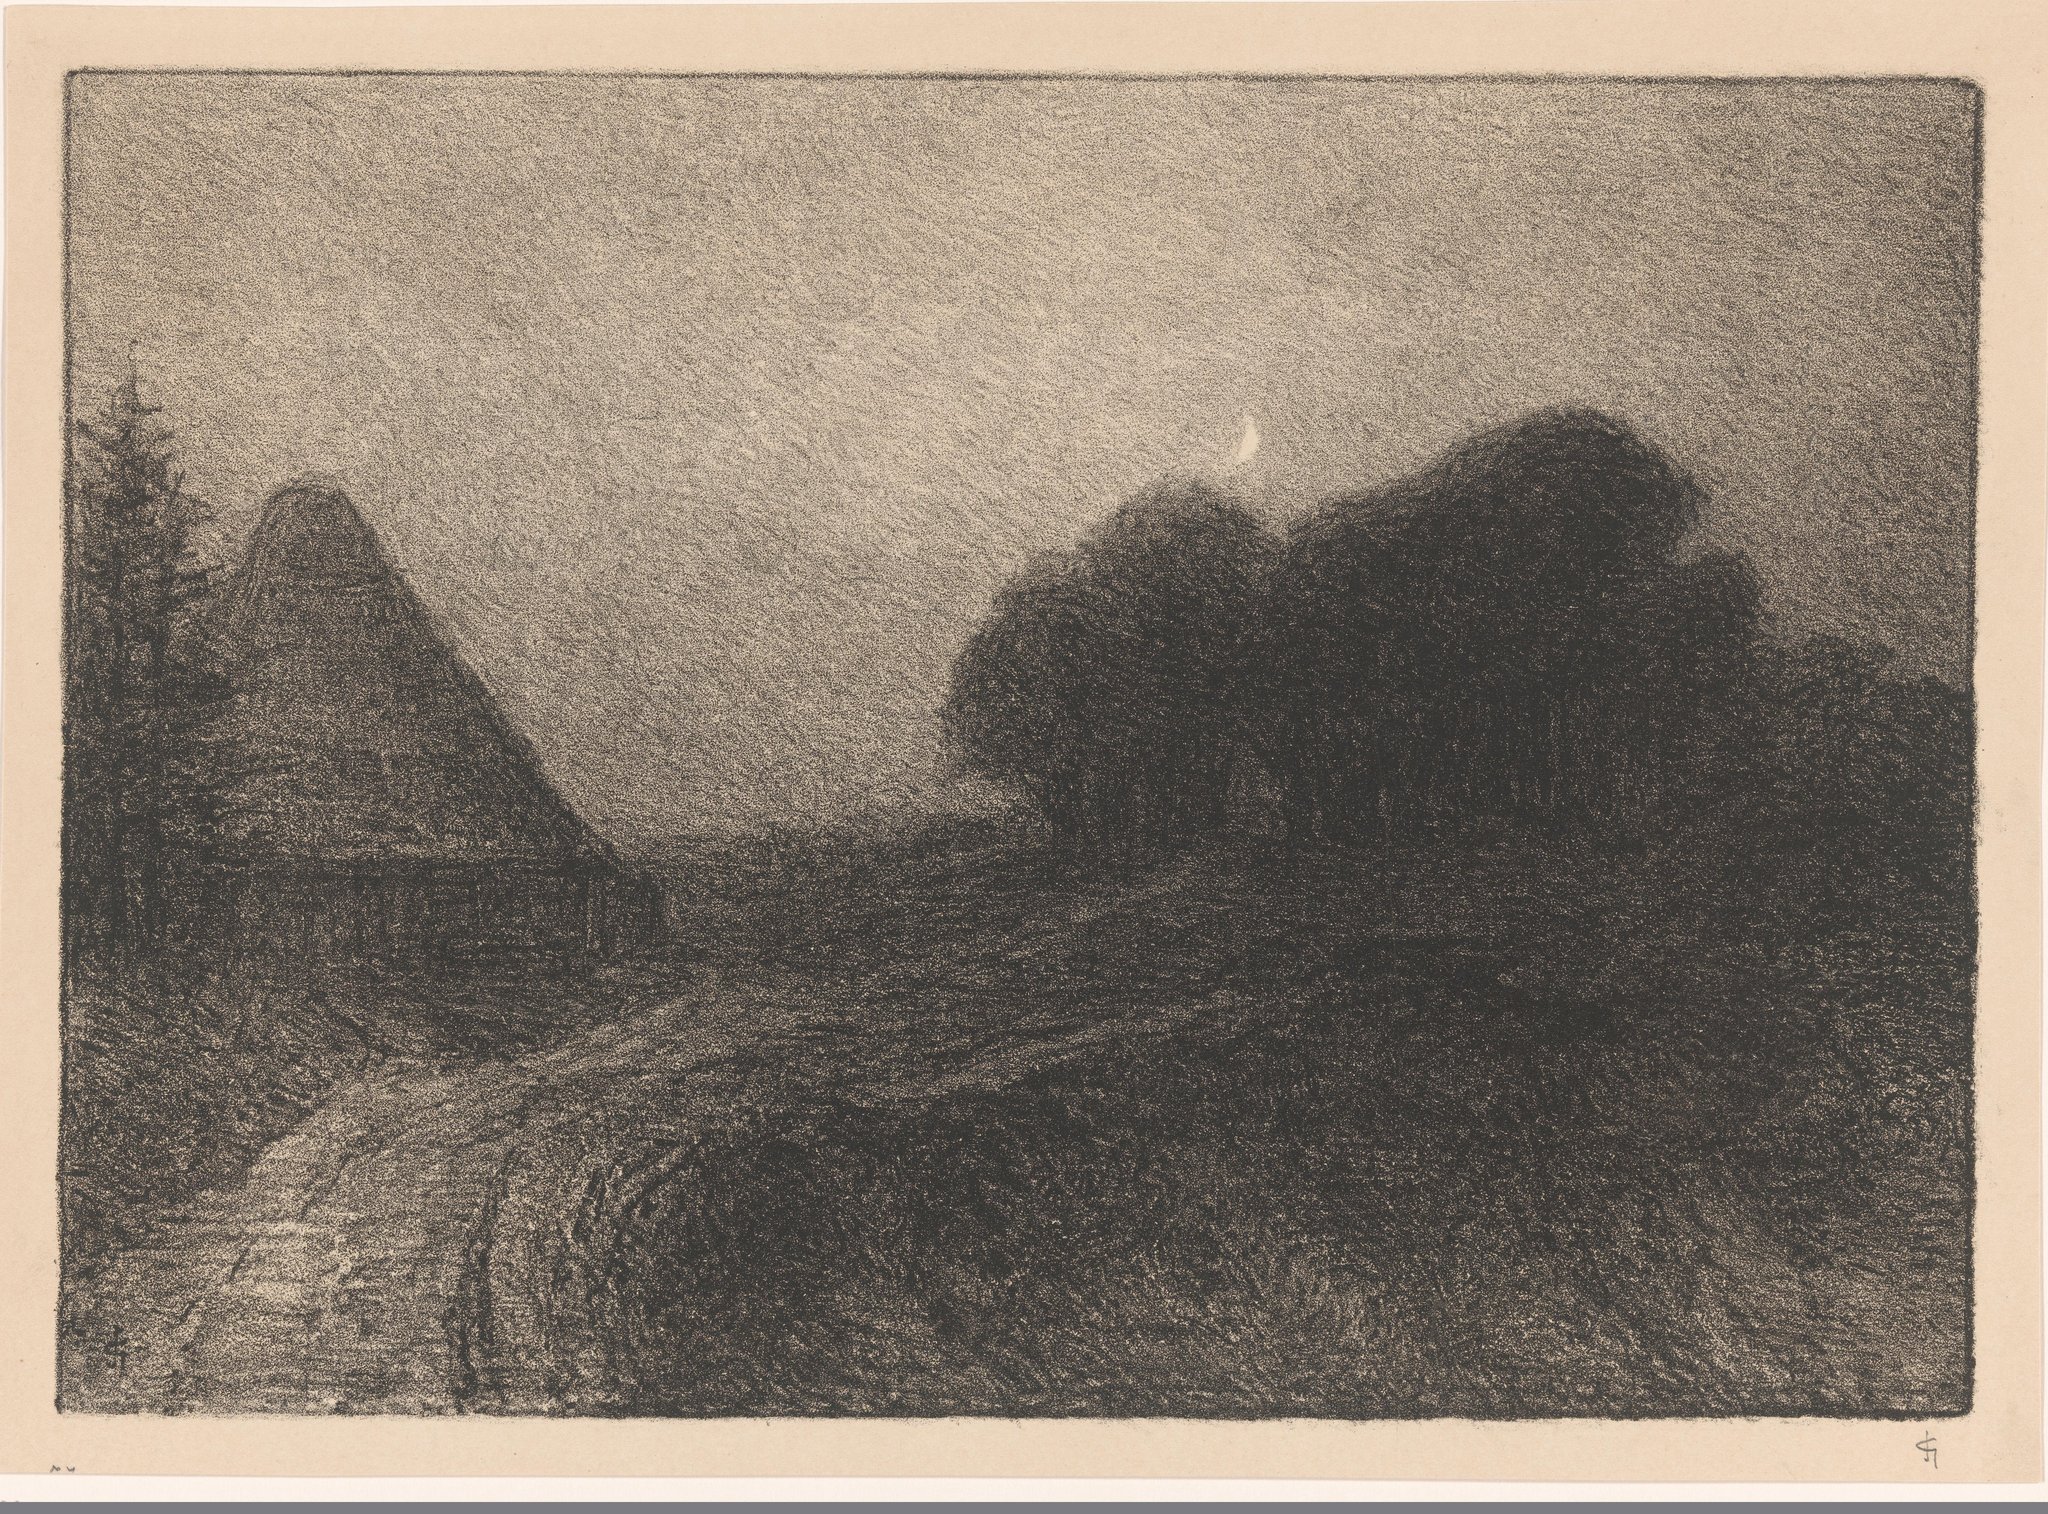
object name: print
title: Nachtelijk landschap bij Kleef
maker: carel nicolaas storm van s-gravesande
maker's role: draughtsman, print maker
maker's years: 1841-1924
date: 1851-1902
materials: paper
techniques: lithograph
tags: barn, landscapes in the temperate zone, night, cleves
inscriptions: collector's mark: Lugt 2228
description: Mogelijk vermeld in: Storm van 's-Gravesande, Charles. Catalogue des eaux-fortes et lithographies. New York: s.n., 1903, of in een onbekende latere uitgave van het manuscript. Vermoedelijk vermeld als catalogusnummer 57.